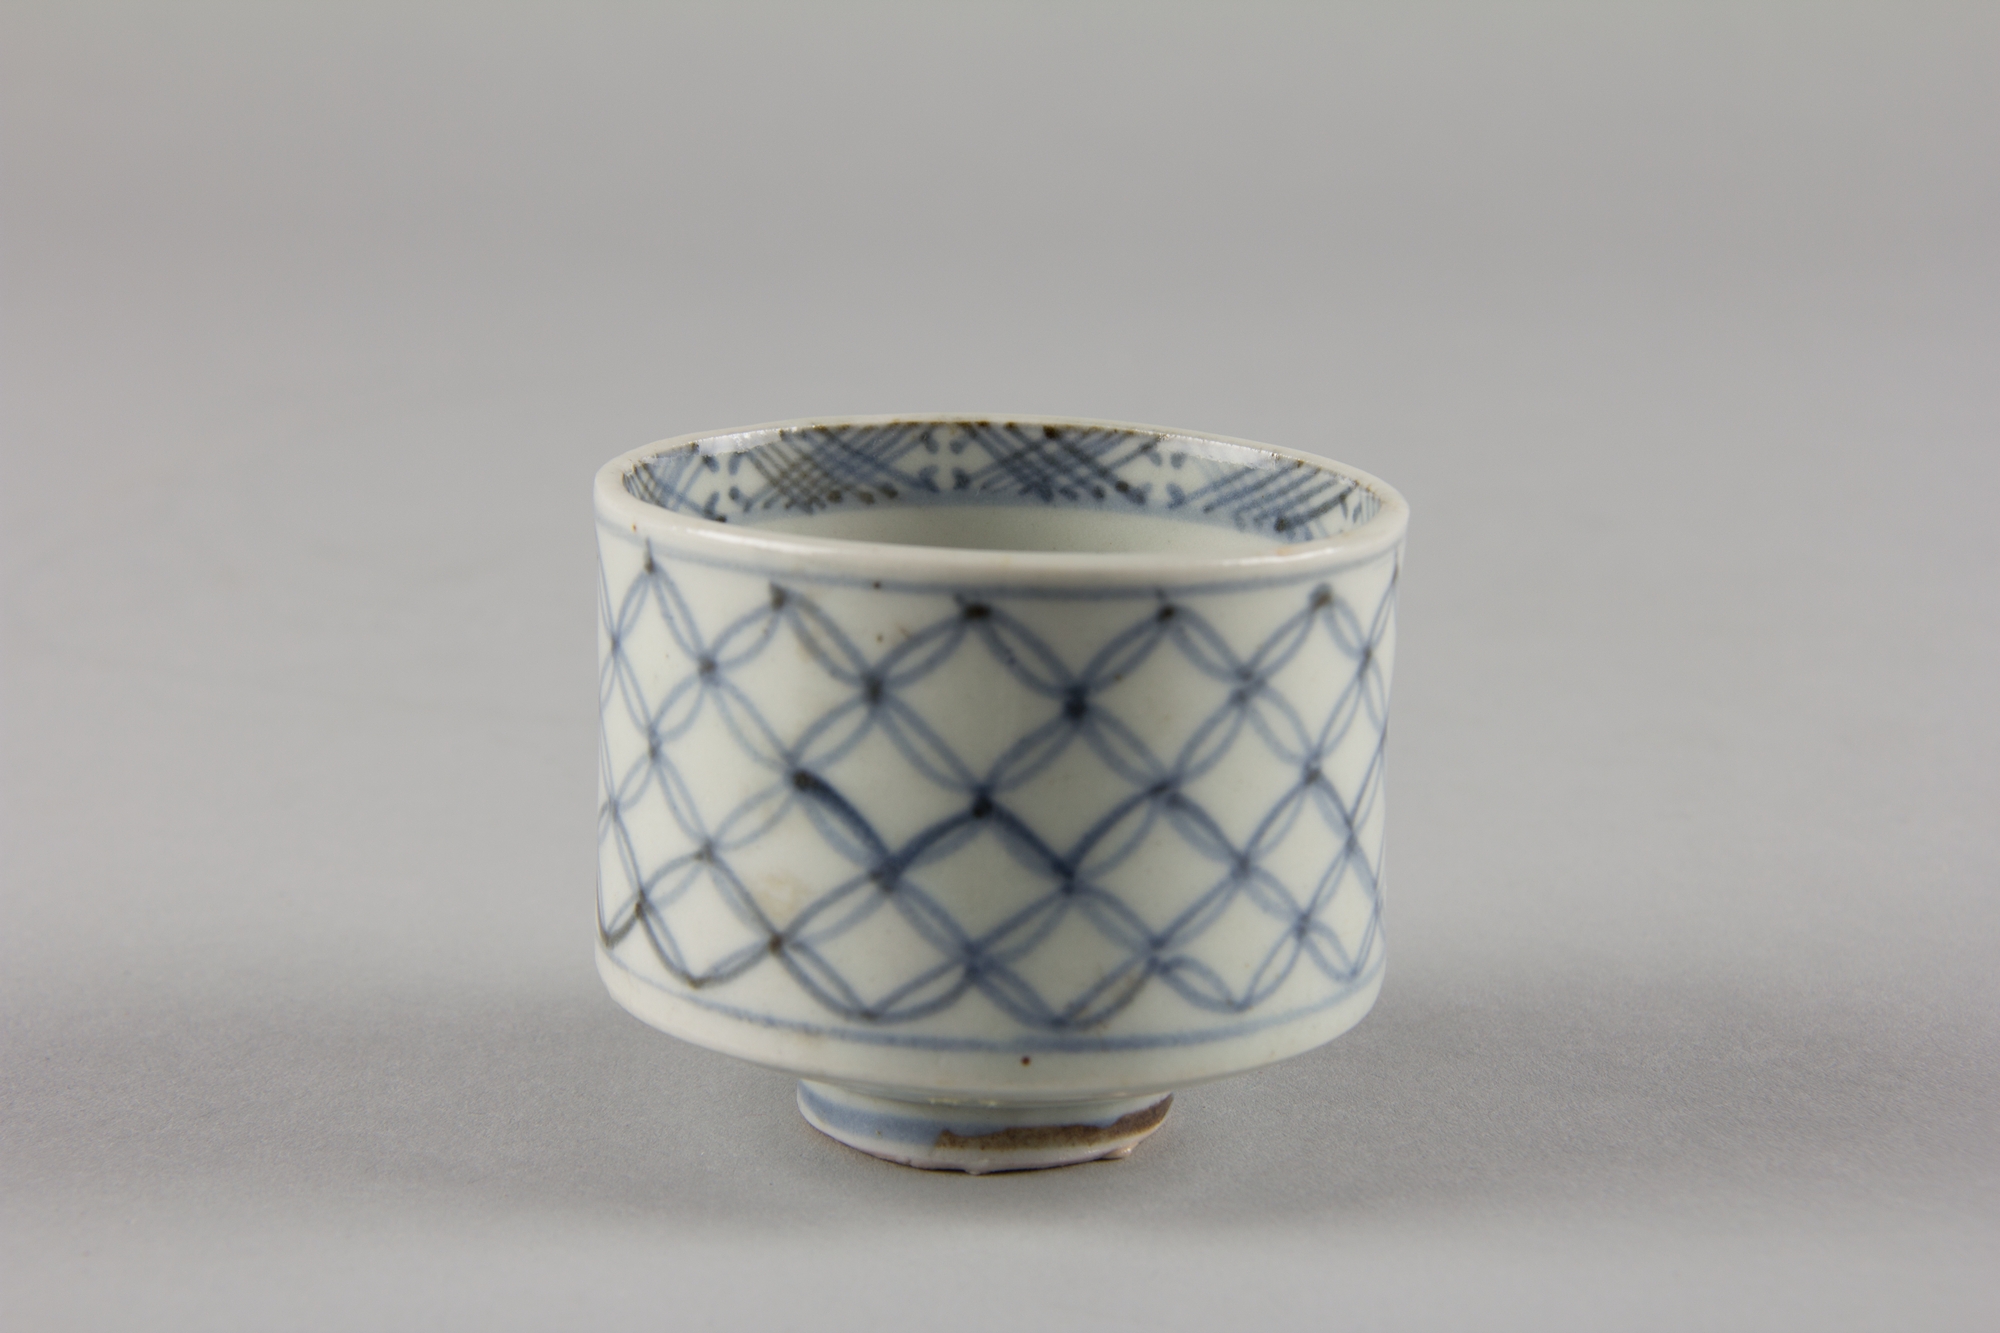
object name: soba cup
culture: japanese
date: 1700-1750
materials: porcelain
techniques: underglaze